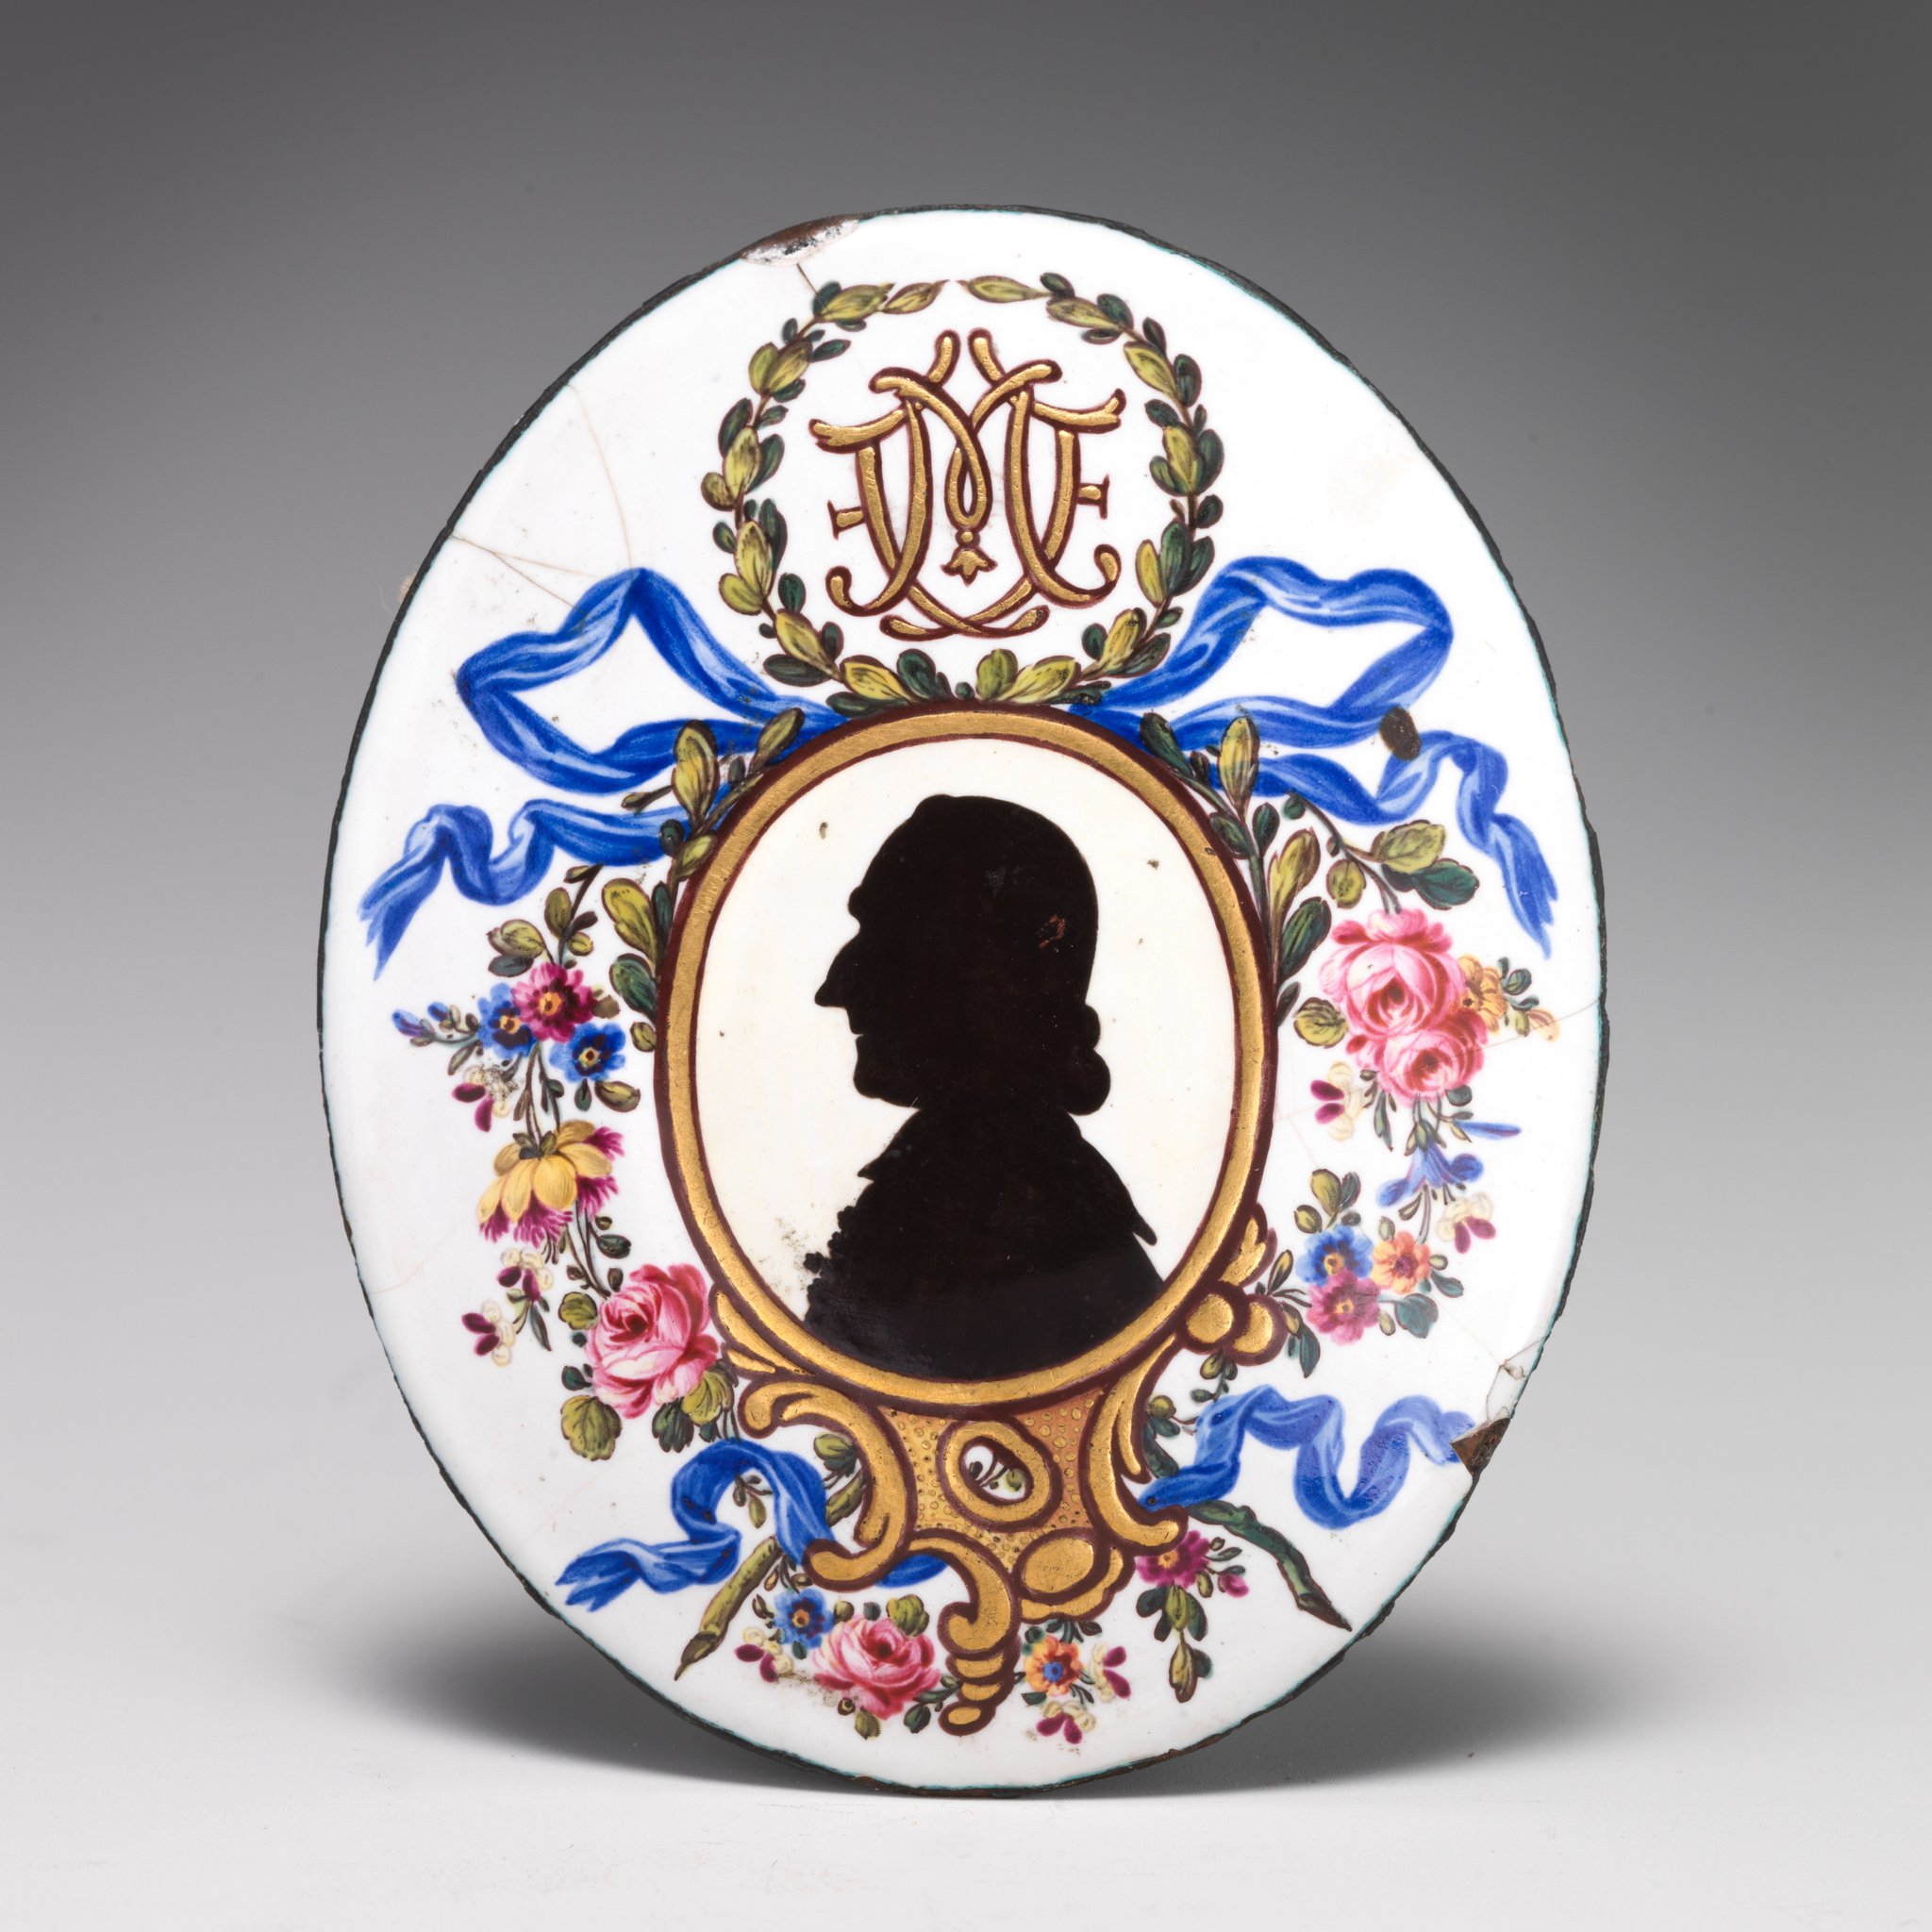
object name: medallion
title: Portrait of a man, possibly La Mothe Fénélon (1651–1715)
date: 1801-1900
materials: copper, enamel, gilt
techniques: painting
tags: men,profiles,insignia